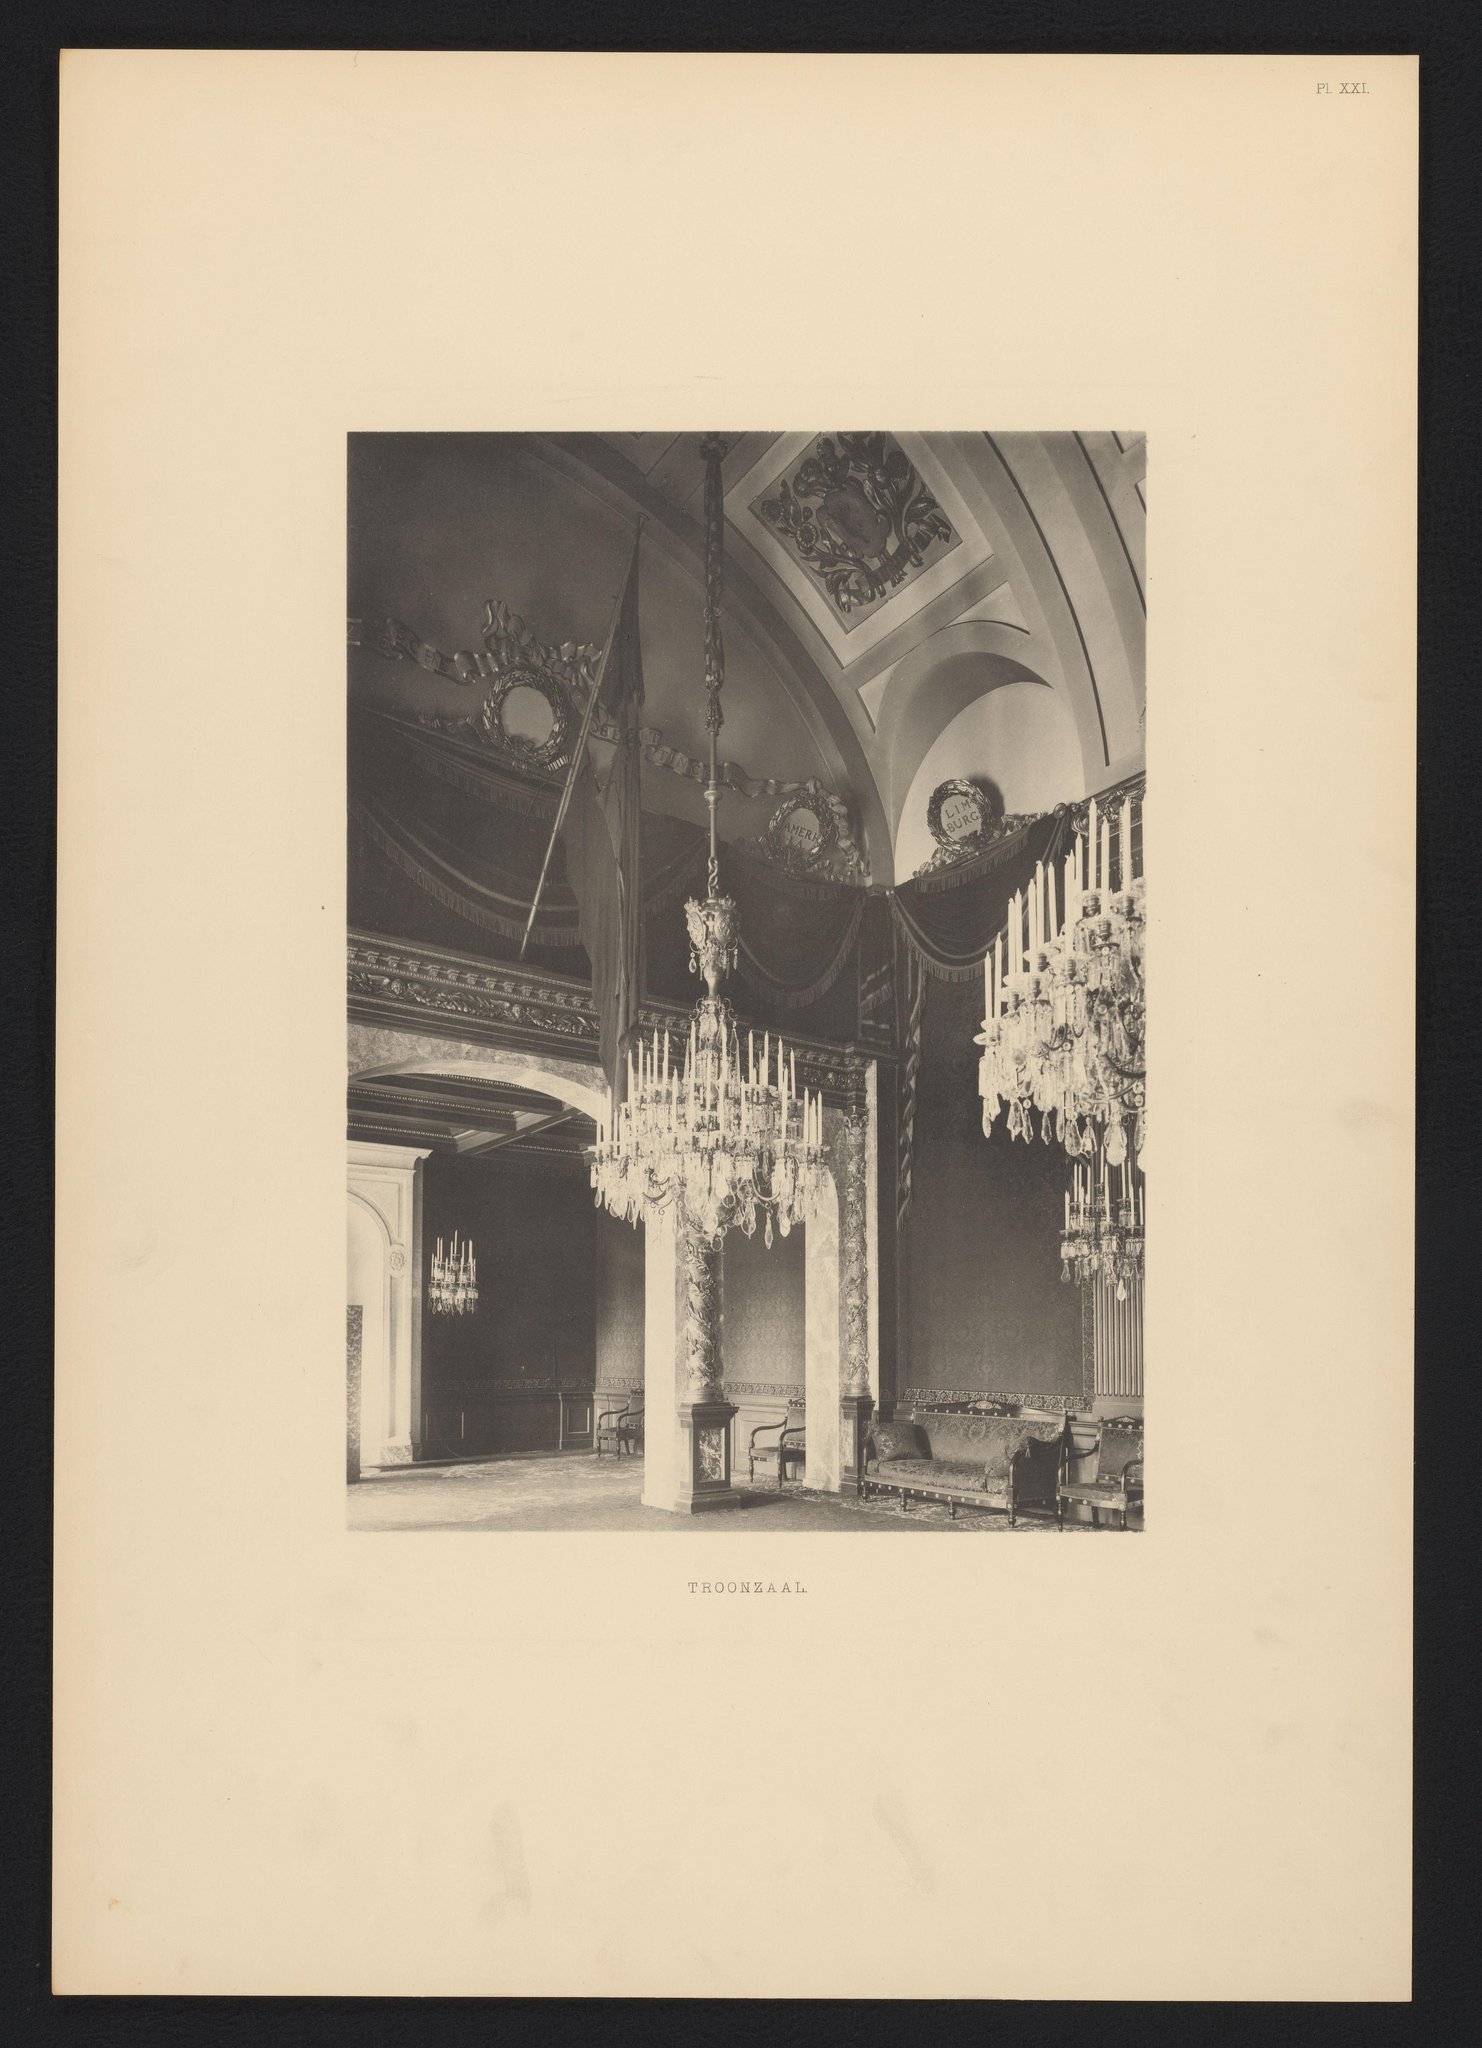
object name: photograph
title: Troonzaal, Paleis op de Dam, Amsterdam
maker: Anonymous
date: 1899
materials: cardboard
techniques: photograph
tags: palace, interior of the house, royal palace of amsterdam